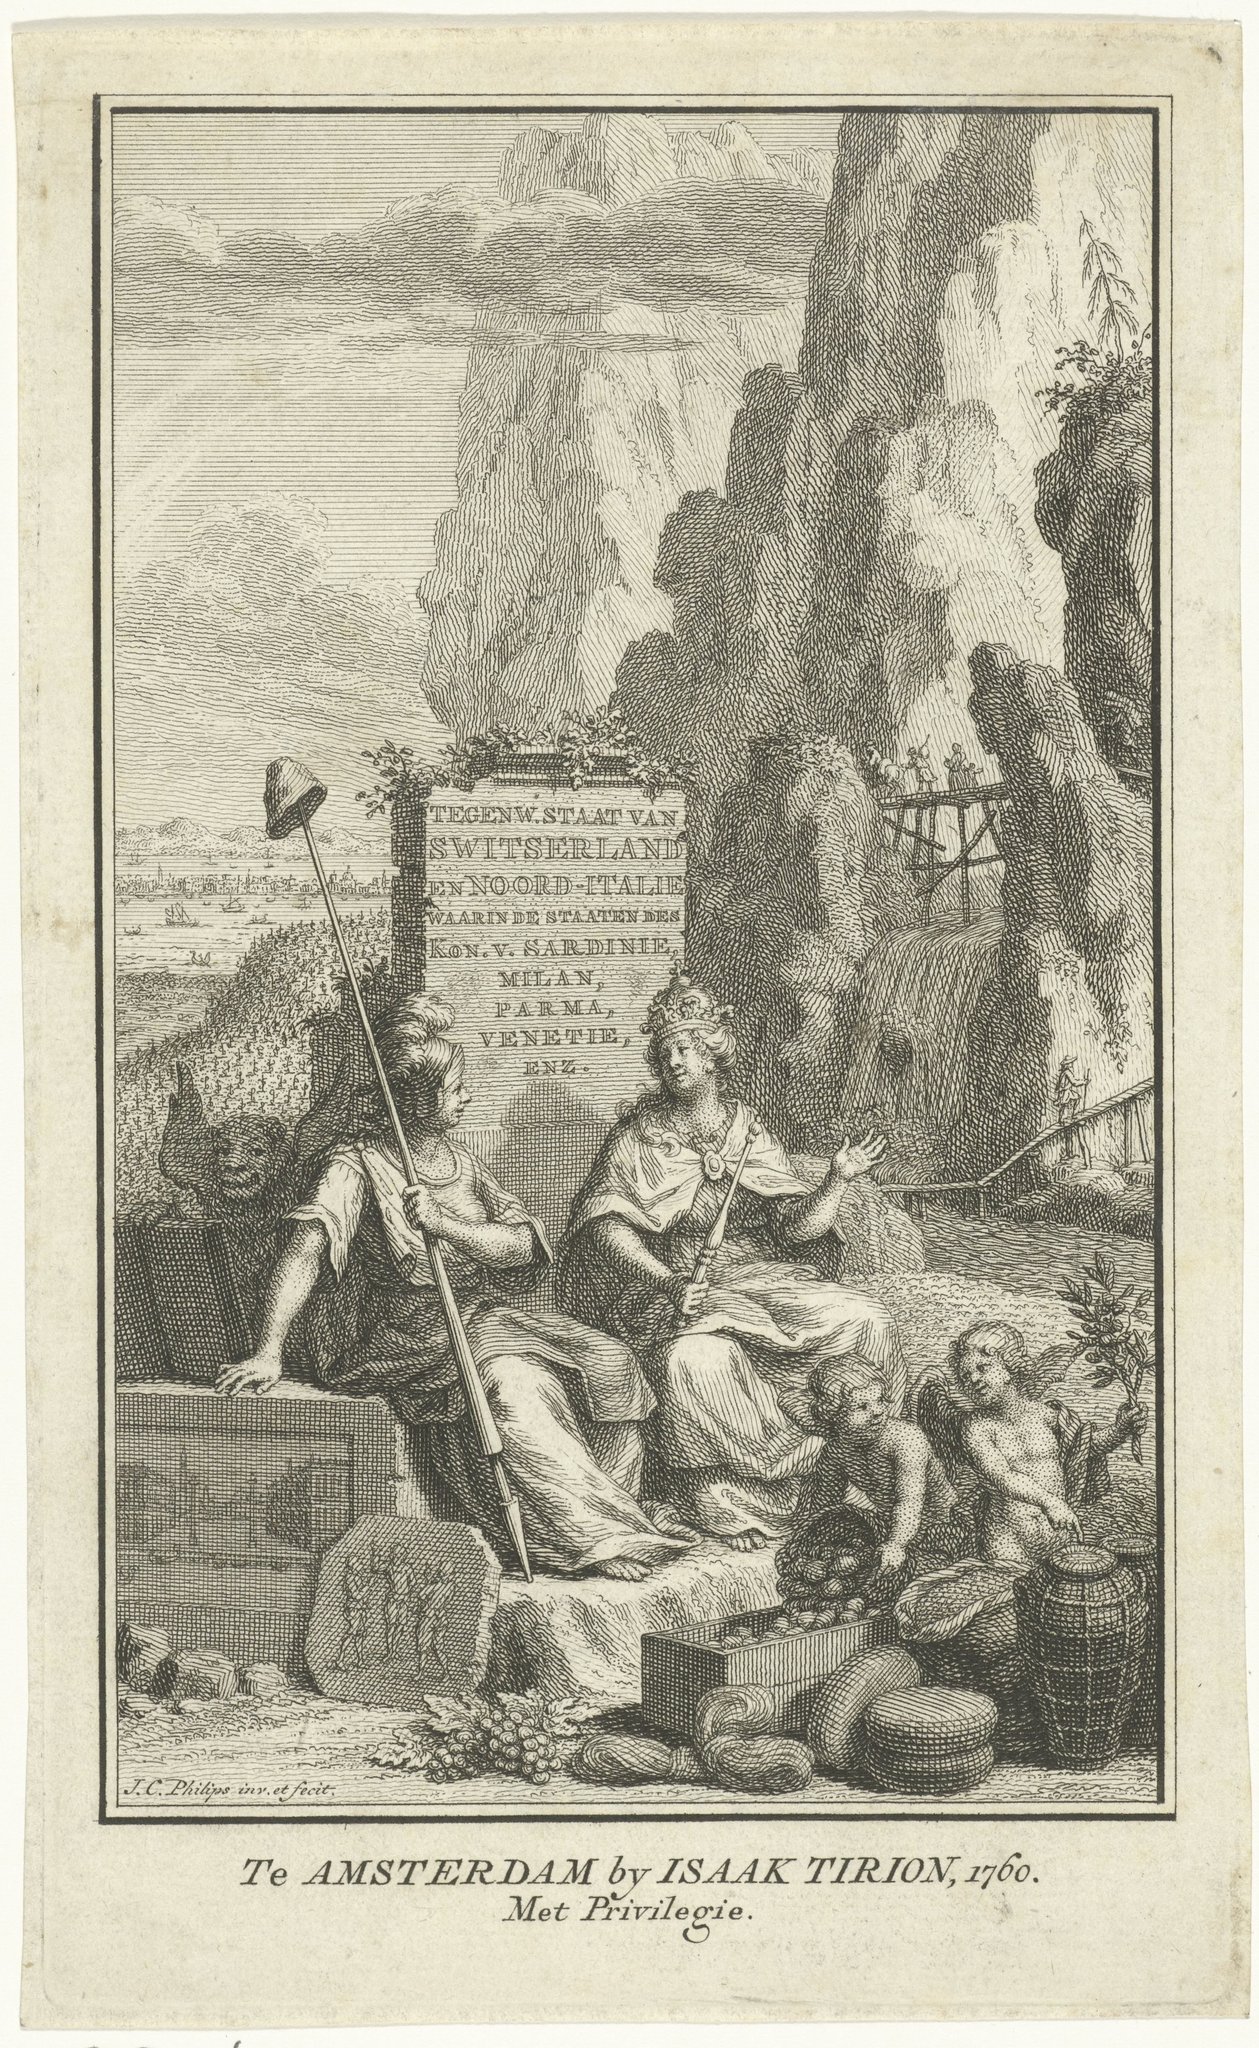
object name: print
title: Titelpagina voor: Thomas Salmon, Hedendaagsche historie of Tegenwoordige staat van Switzerland en Italie,1760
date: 1760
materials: paper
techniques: engraving, etching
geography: amsterdam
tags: freedom, liberty; 'libertà' (ripa), allegory, personification of good government, symbols of particular nations, states, districts, etc., mountains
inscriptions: collector's mark: Lugt 2228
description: Bergachtig landschap met de personificaties van Vrijheid en Goed Bestuur. Op een ruïne achter hen de titel in het Nederlands. Links de gevleugelde leeuw van de H. Marcus, het symbool van Venetië. Op de voorgrond twee putti met de rijkdommen van het gebied.